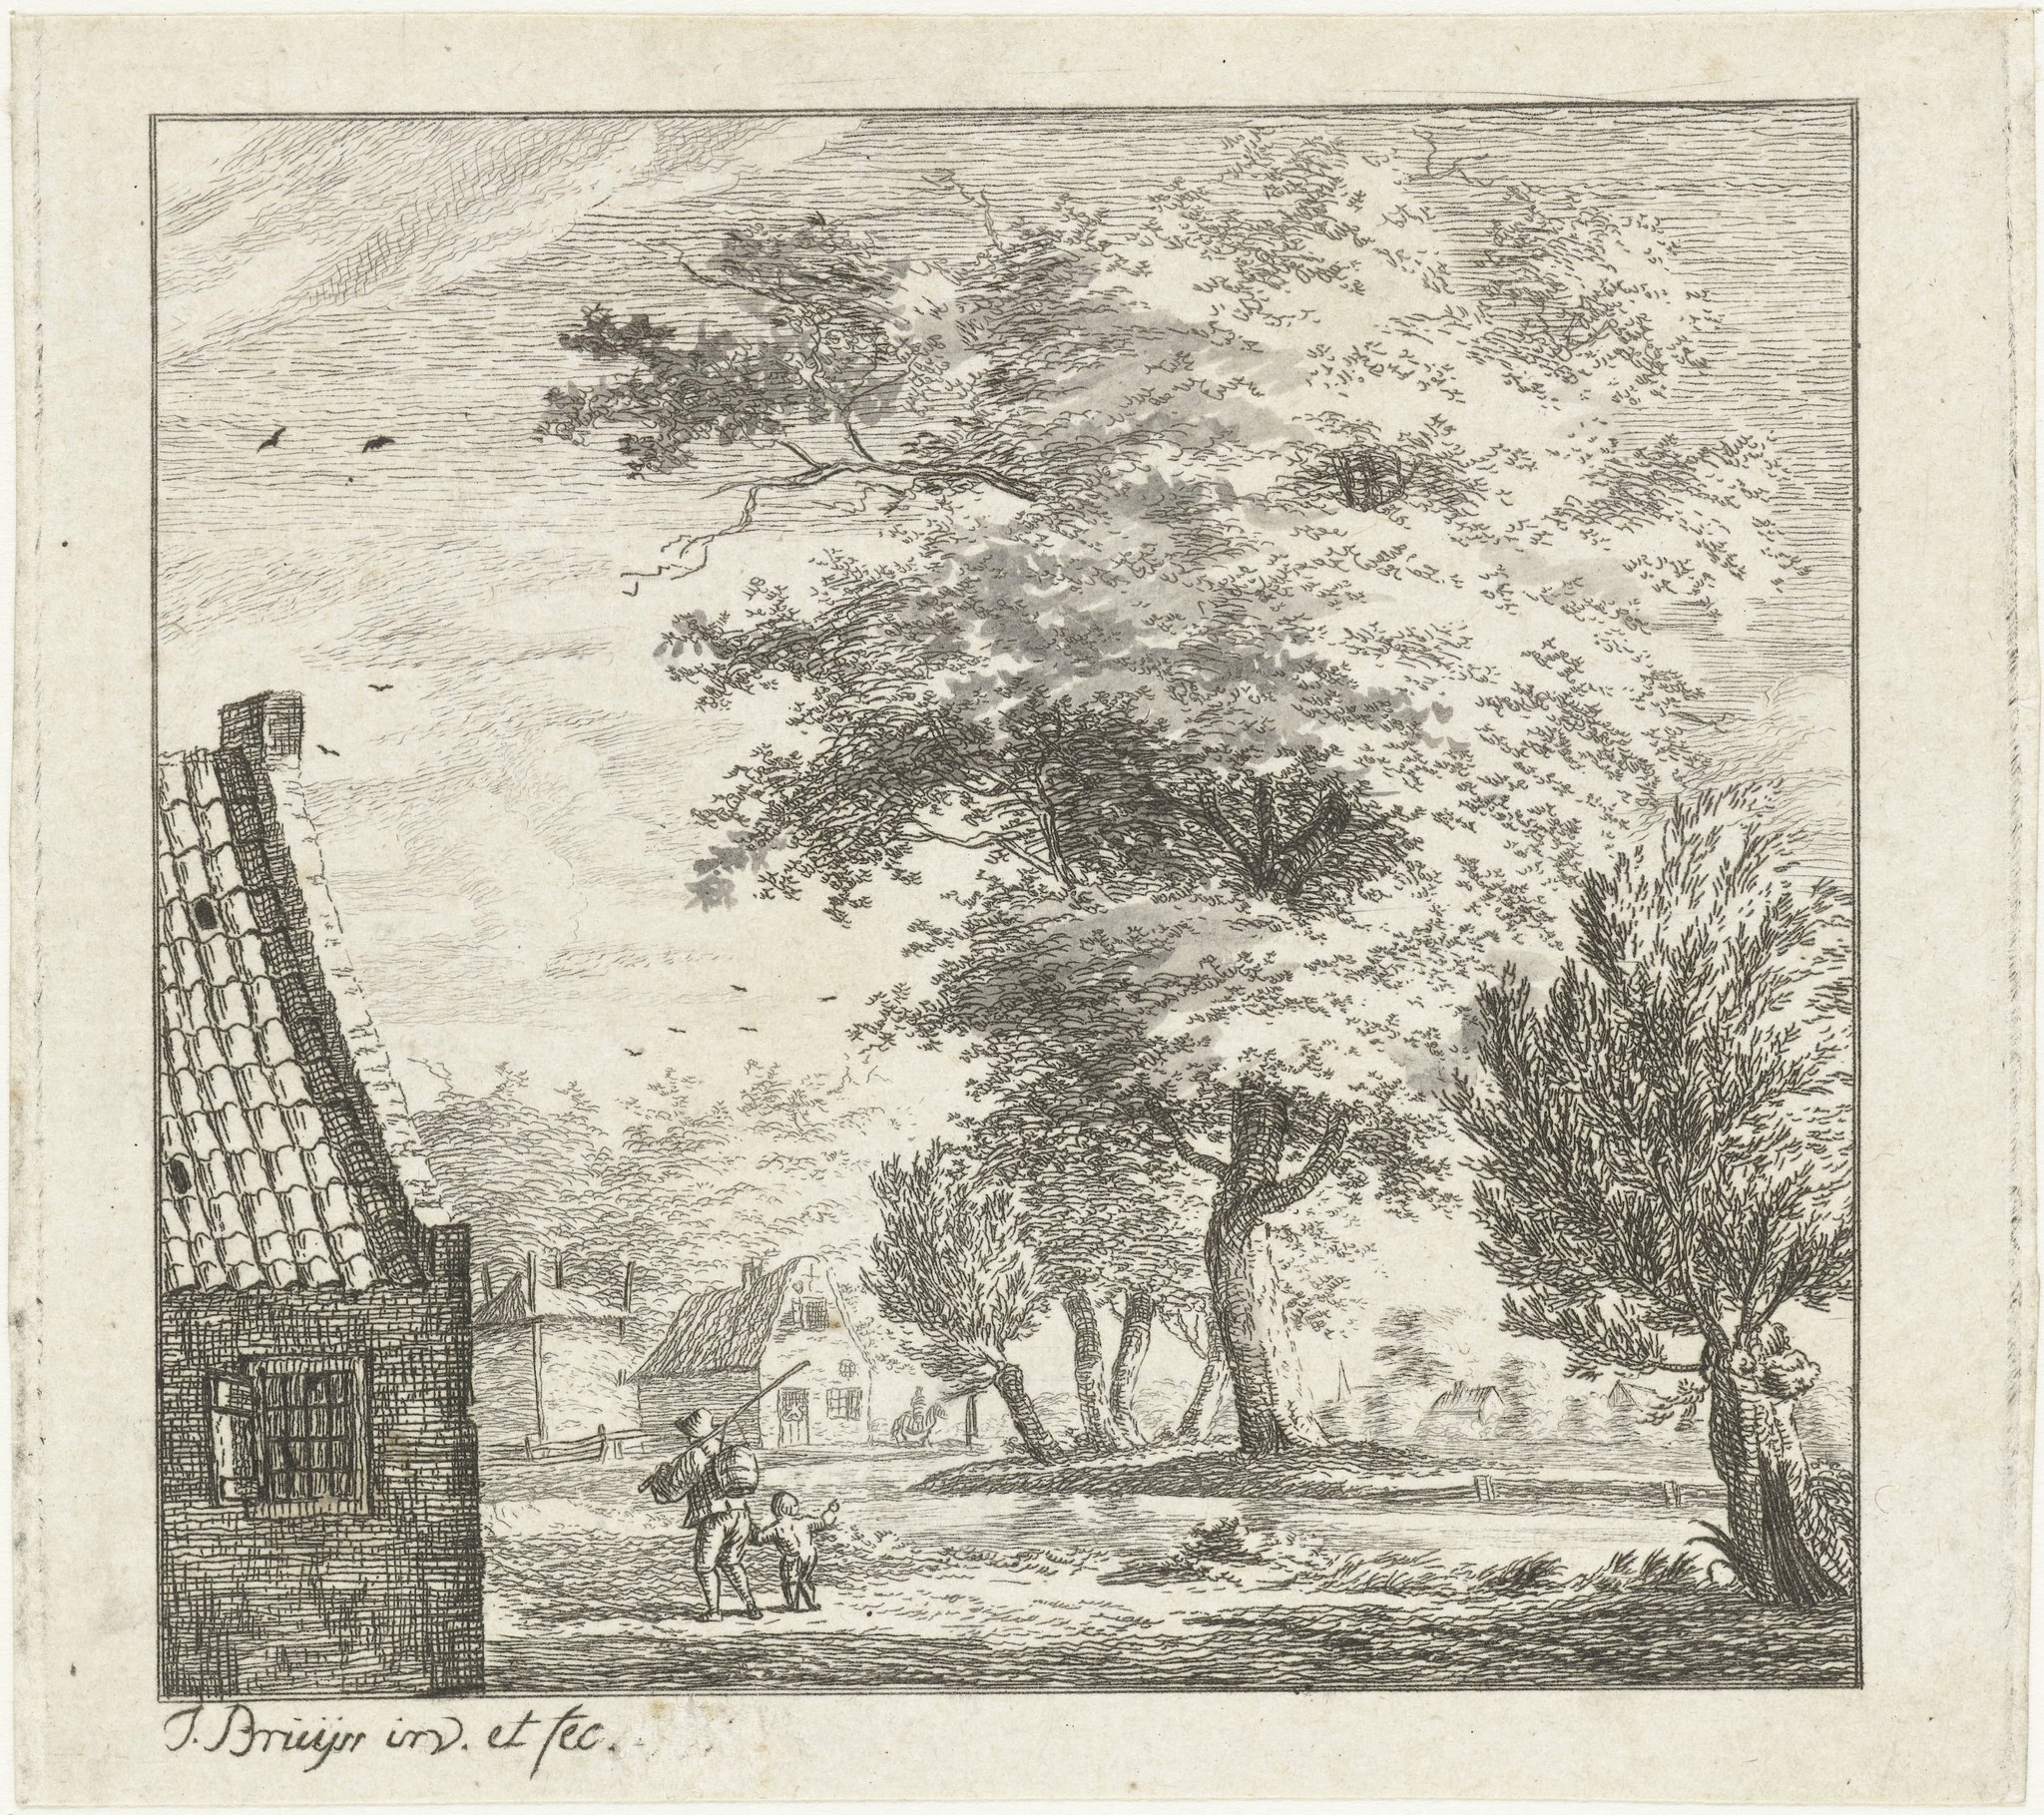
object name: print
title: Dorpsgezicht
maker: johanna de bruyn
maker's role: draughtsman, print maker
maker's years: 1722-1782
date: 1732-1782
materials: paper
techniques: etching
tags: public road in village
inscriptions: collector's mark: Lugt 2228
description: Een weg langs de rand van een dorp. Links een woning met pannen dak. Rechts een wilgenboom langs een rivier. Op de weg een wandelaar en zijn zoontje.